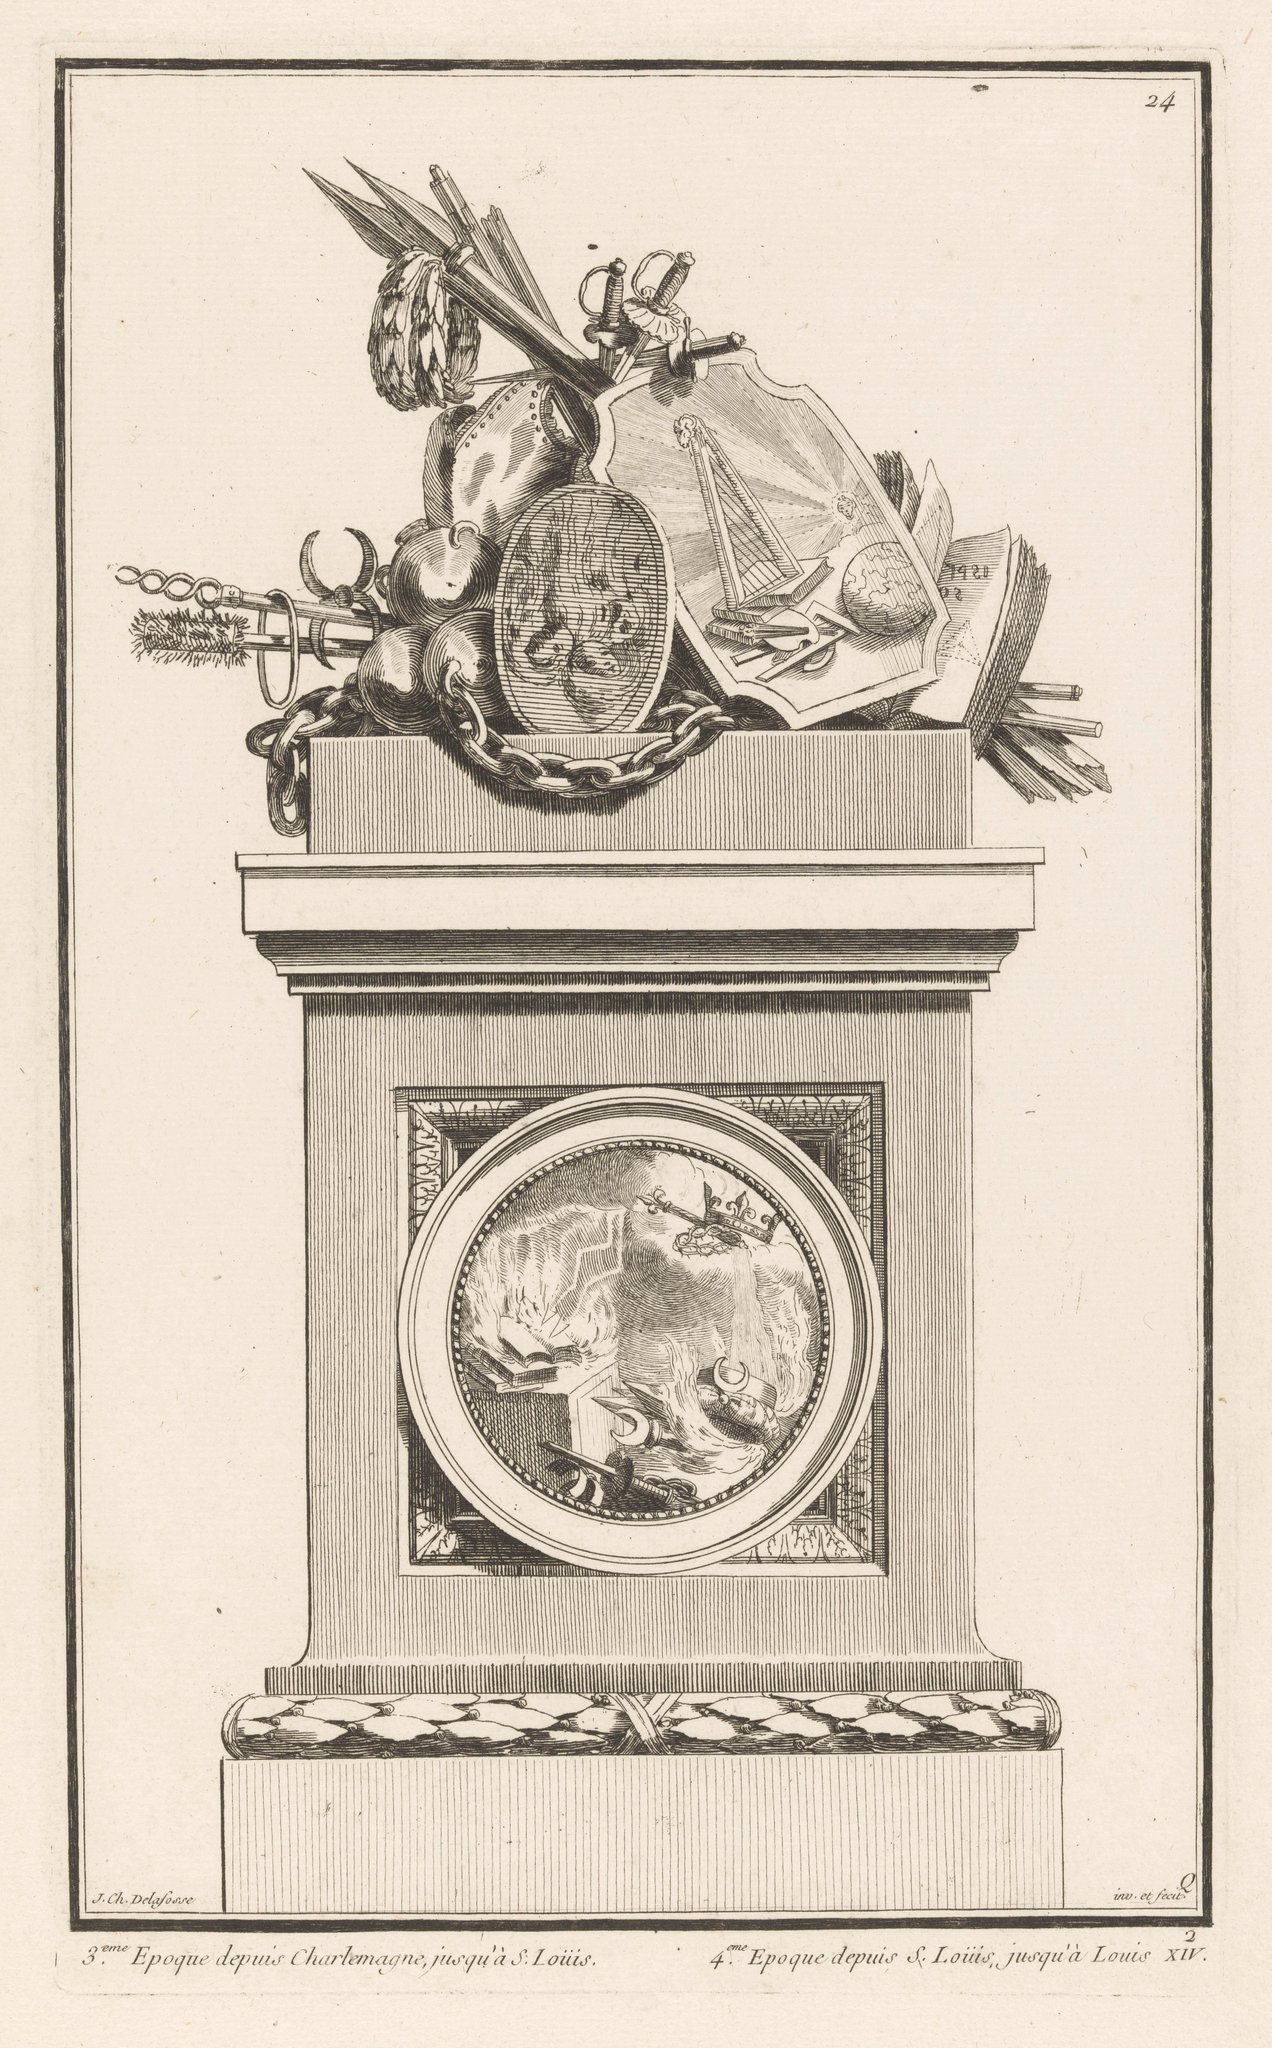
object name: ornament print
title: Q Piedestaux et Socles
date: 1768-1771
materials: paper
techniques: engraving, etching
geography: paris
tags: lodewijk xiv (koning van frankrijk), charlemagne (holy roman emperor), pedestal of a piece of sculpture (perhaps in the form of a herm)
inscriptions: collector's mark: Lugt 2228, collector's mark: Lugt 2760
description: Een voetstuk met een rond medaillon met brandende boeken, een brandende tulband, een kroon, een scepter met fleur-de-lis en een doornenkroon. Op het voetstuk liggen wapens, lauwerkransen, een schild met brandende maskers, boeken en een schild met de zon, boeken, schildersattributen en een globe. Prentnummer 24.